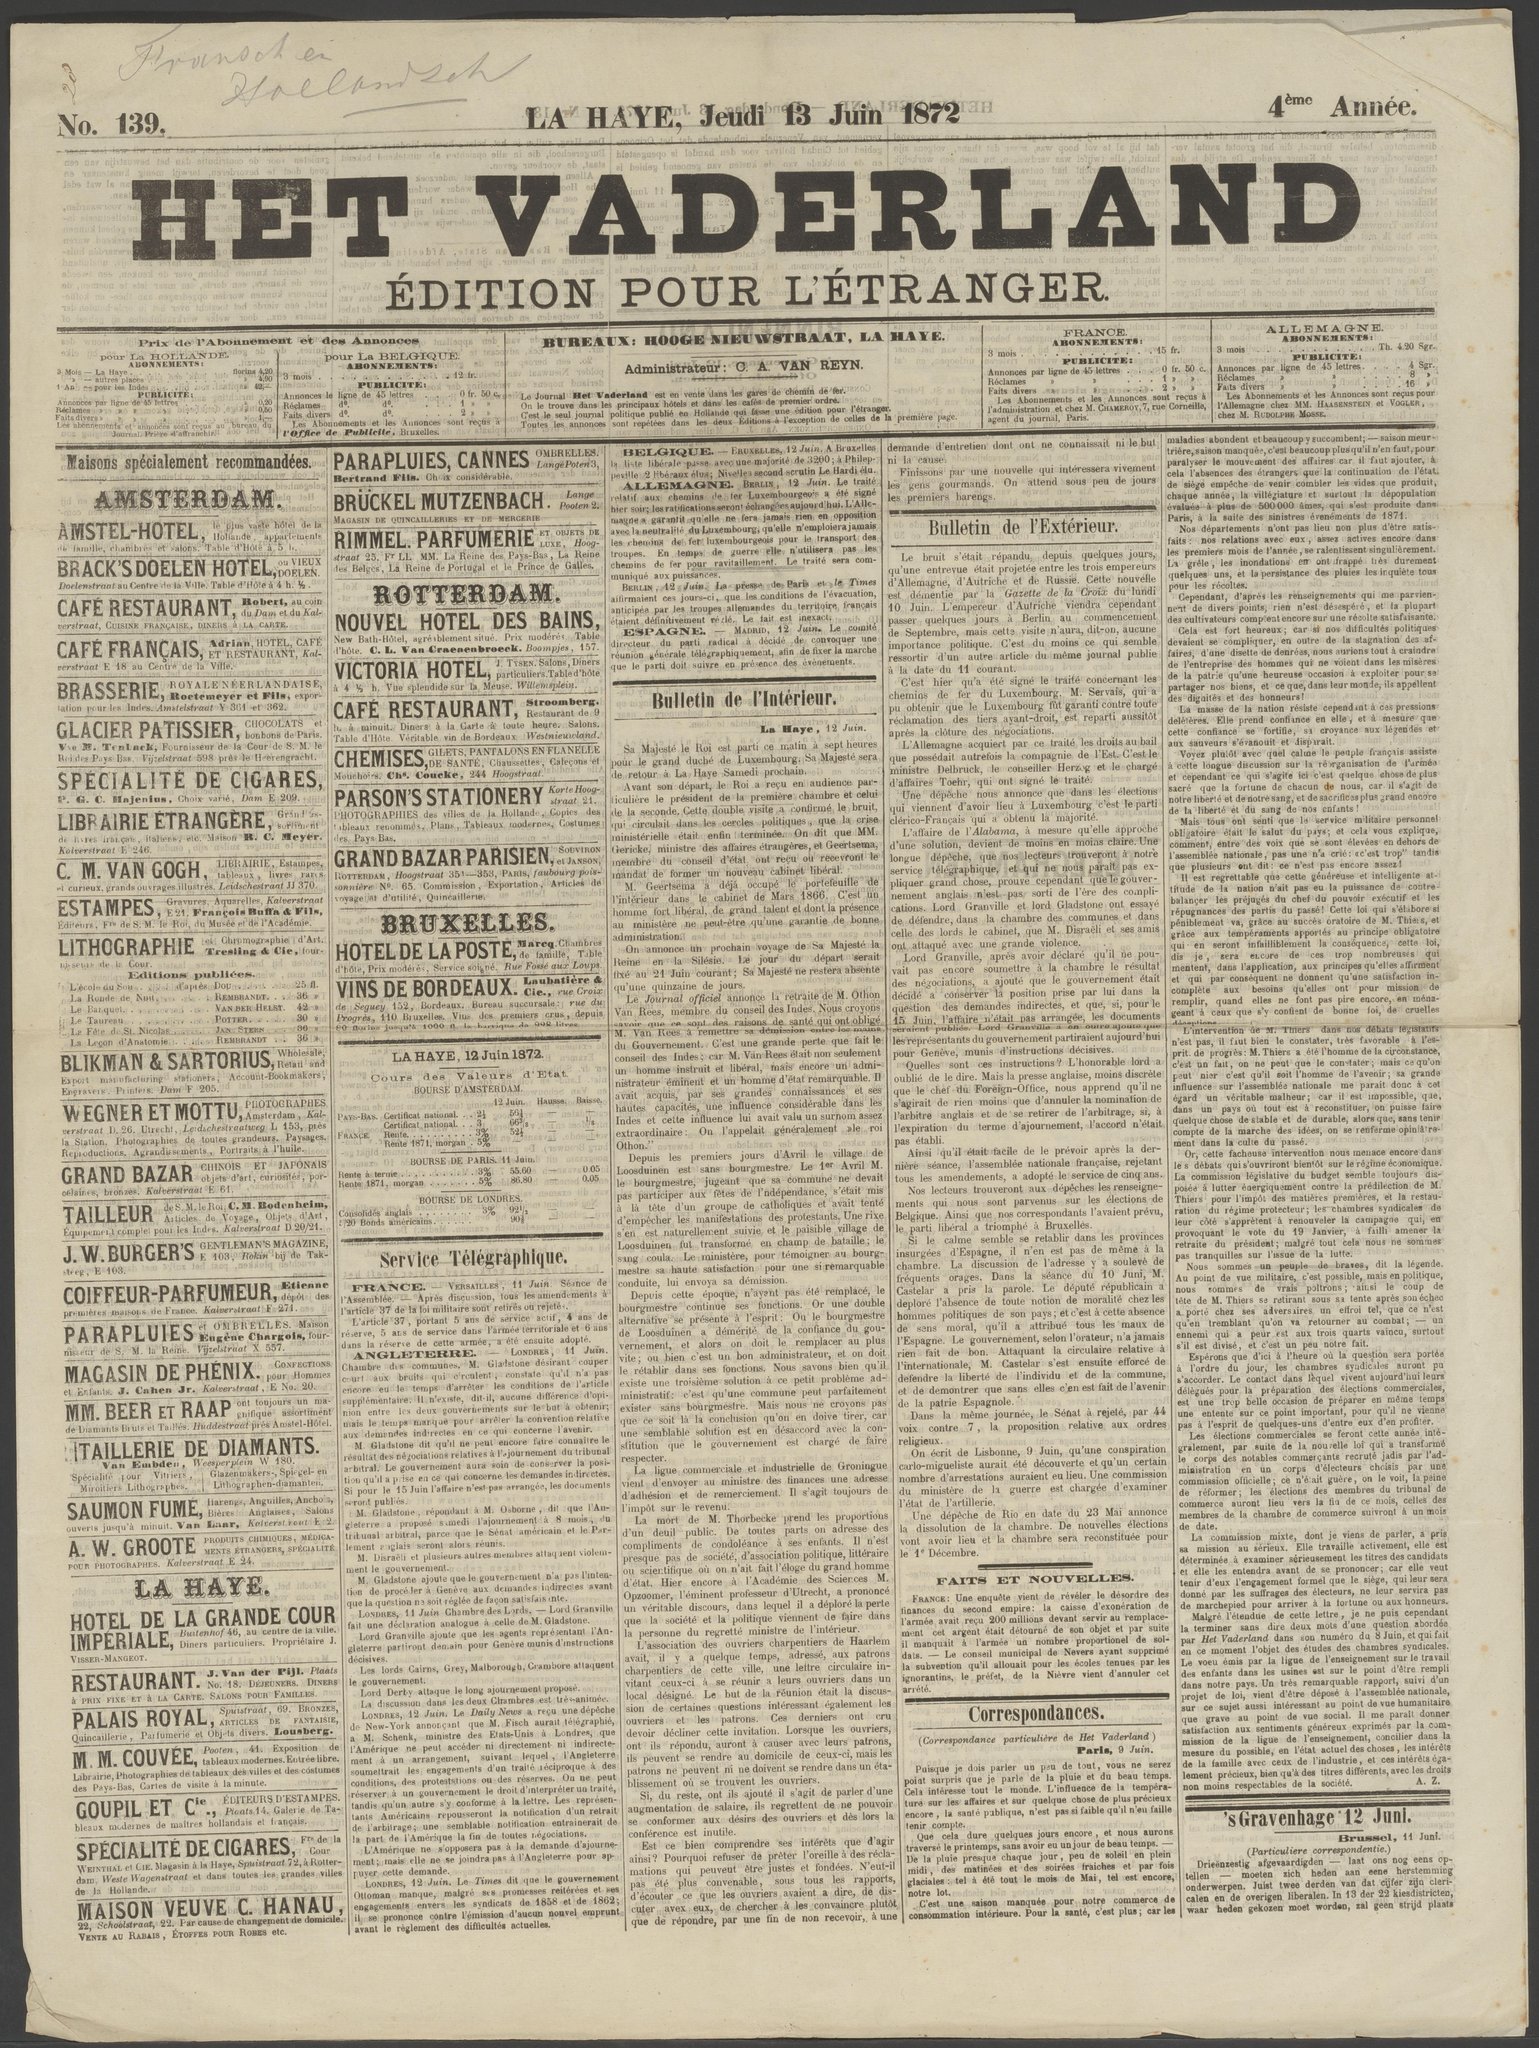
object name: newspaper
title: Het Vaderland / Édition pour l'Étranger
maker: c.a. van reyn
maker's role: printer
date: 1872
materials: paper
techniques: letterpress printing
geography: the hague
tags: newspaper, news-sheet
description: Exemplaar van de krant 'Het Vaderland / Édition pour l'Étranger' van 13 juni 1872. Dubbelbladig, alle zijden bedrukt. Onderwerpsrubrieken binnen de Atlas Zeden en Gewoonten: Regeering, Officieele Nieuwsbladen.